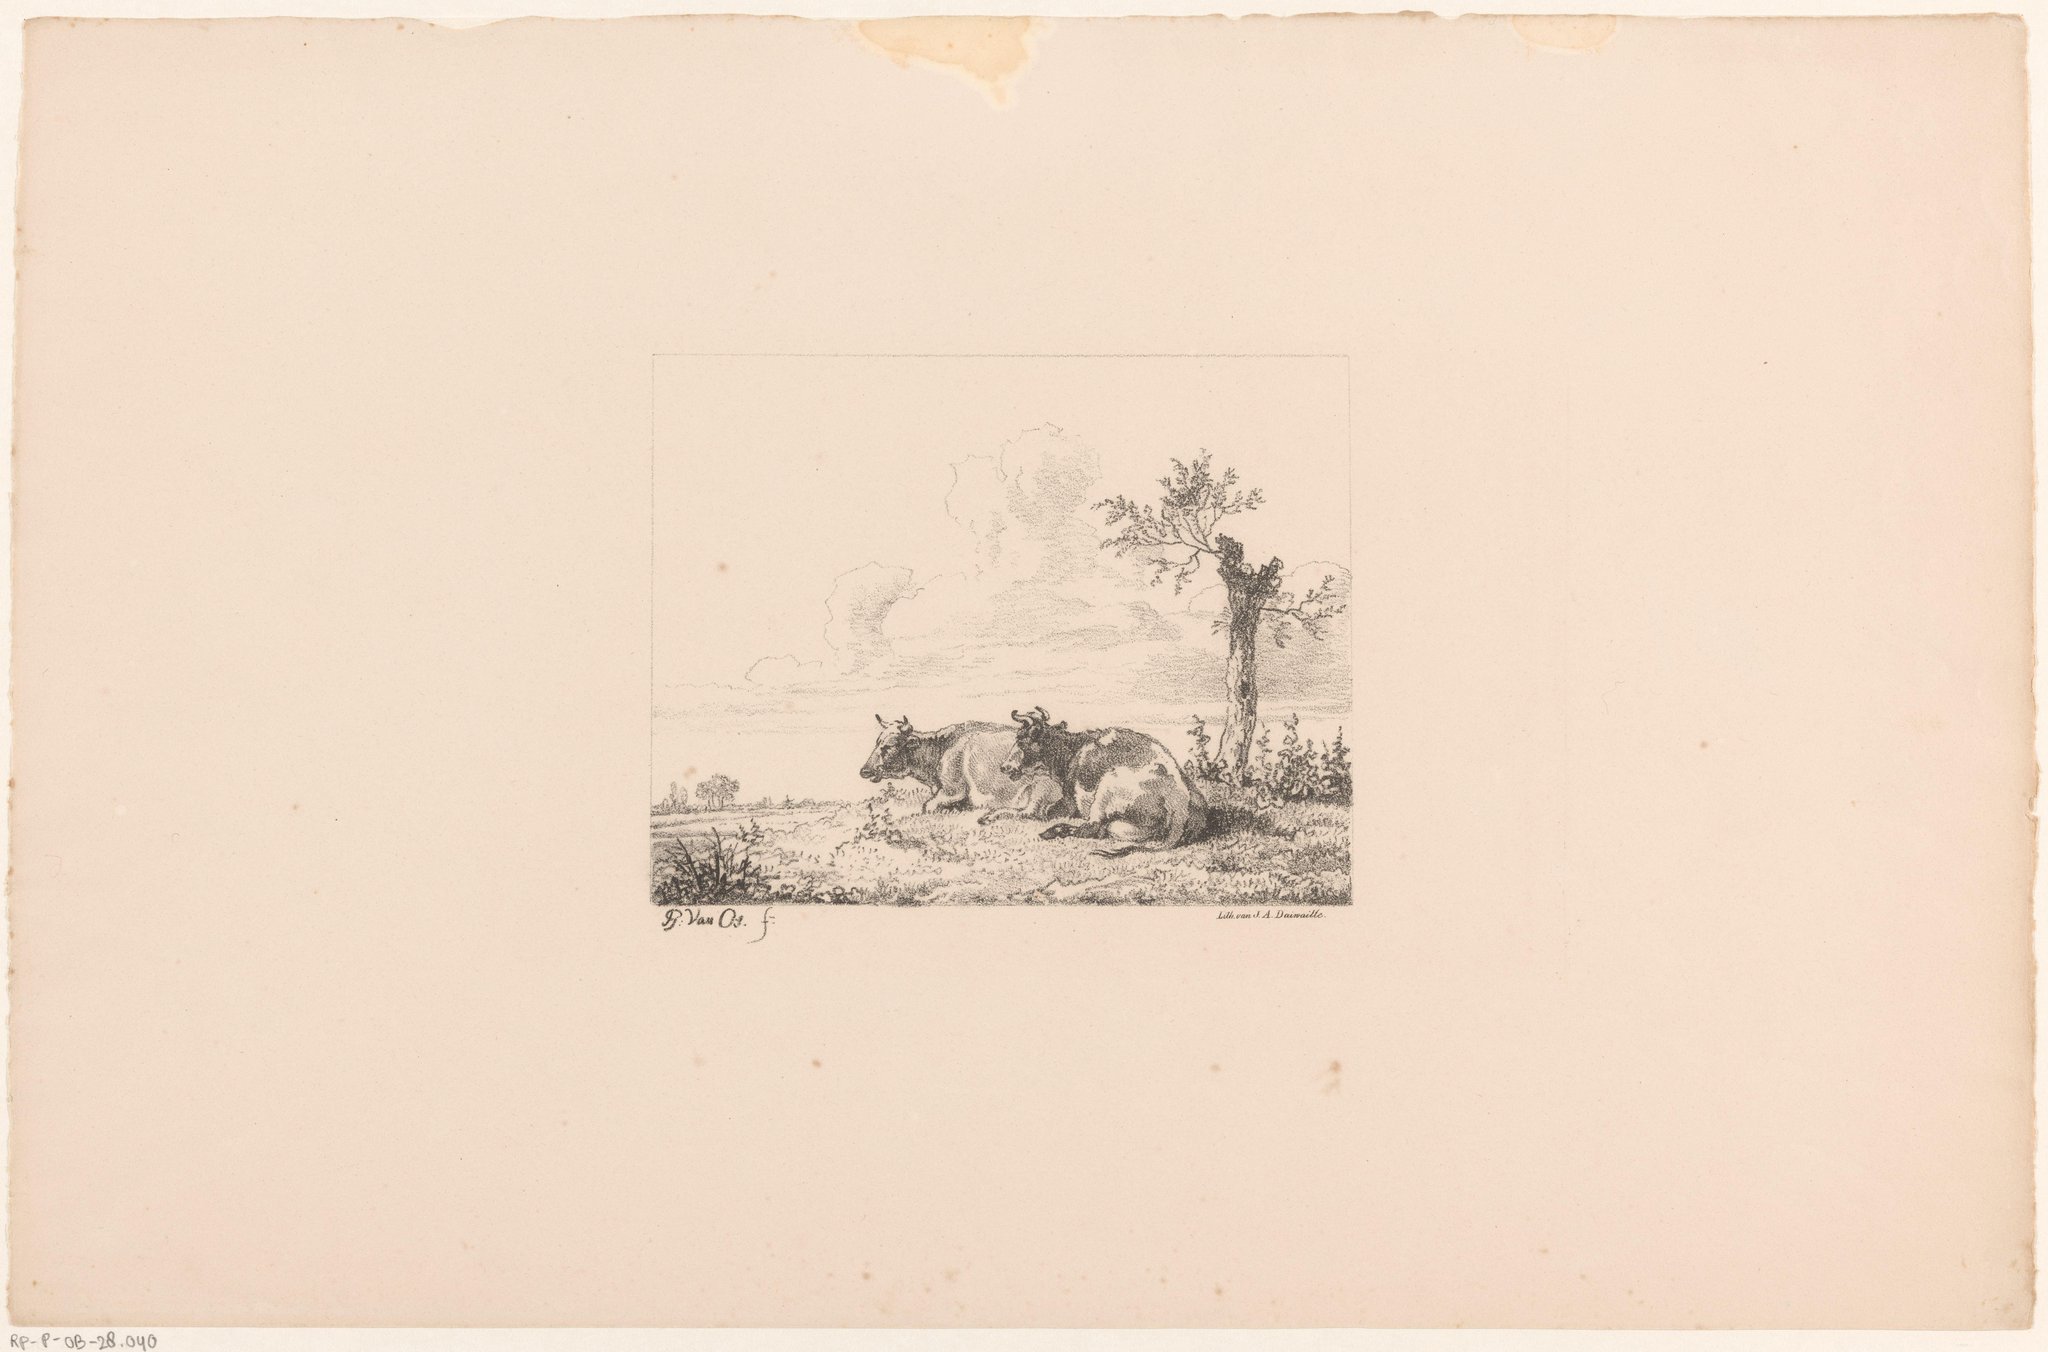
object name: print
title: Twee liggende koeien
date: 1828-1830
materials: paper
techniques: lithograph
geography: netherlands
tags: cow, meadow, pasture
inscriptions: collector's mark: Lugt 2228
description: De koeien liggen in een weiland bij een boom.